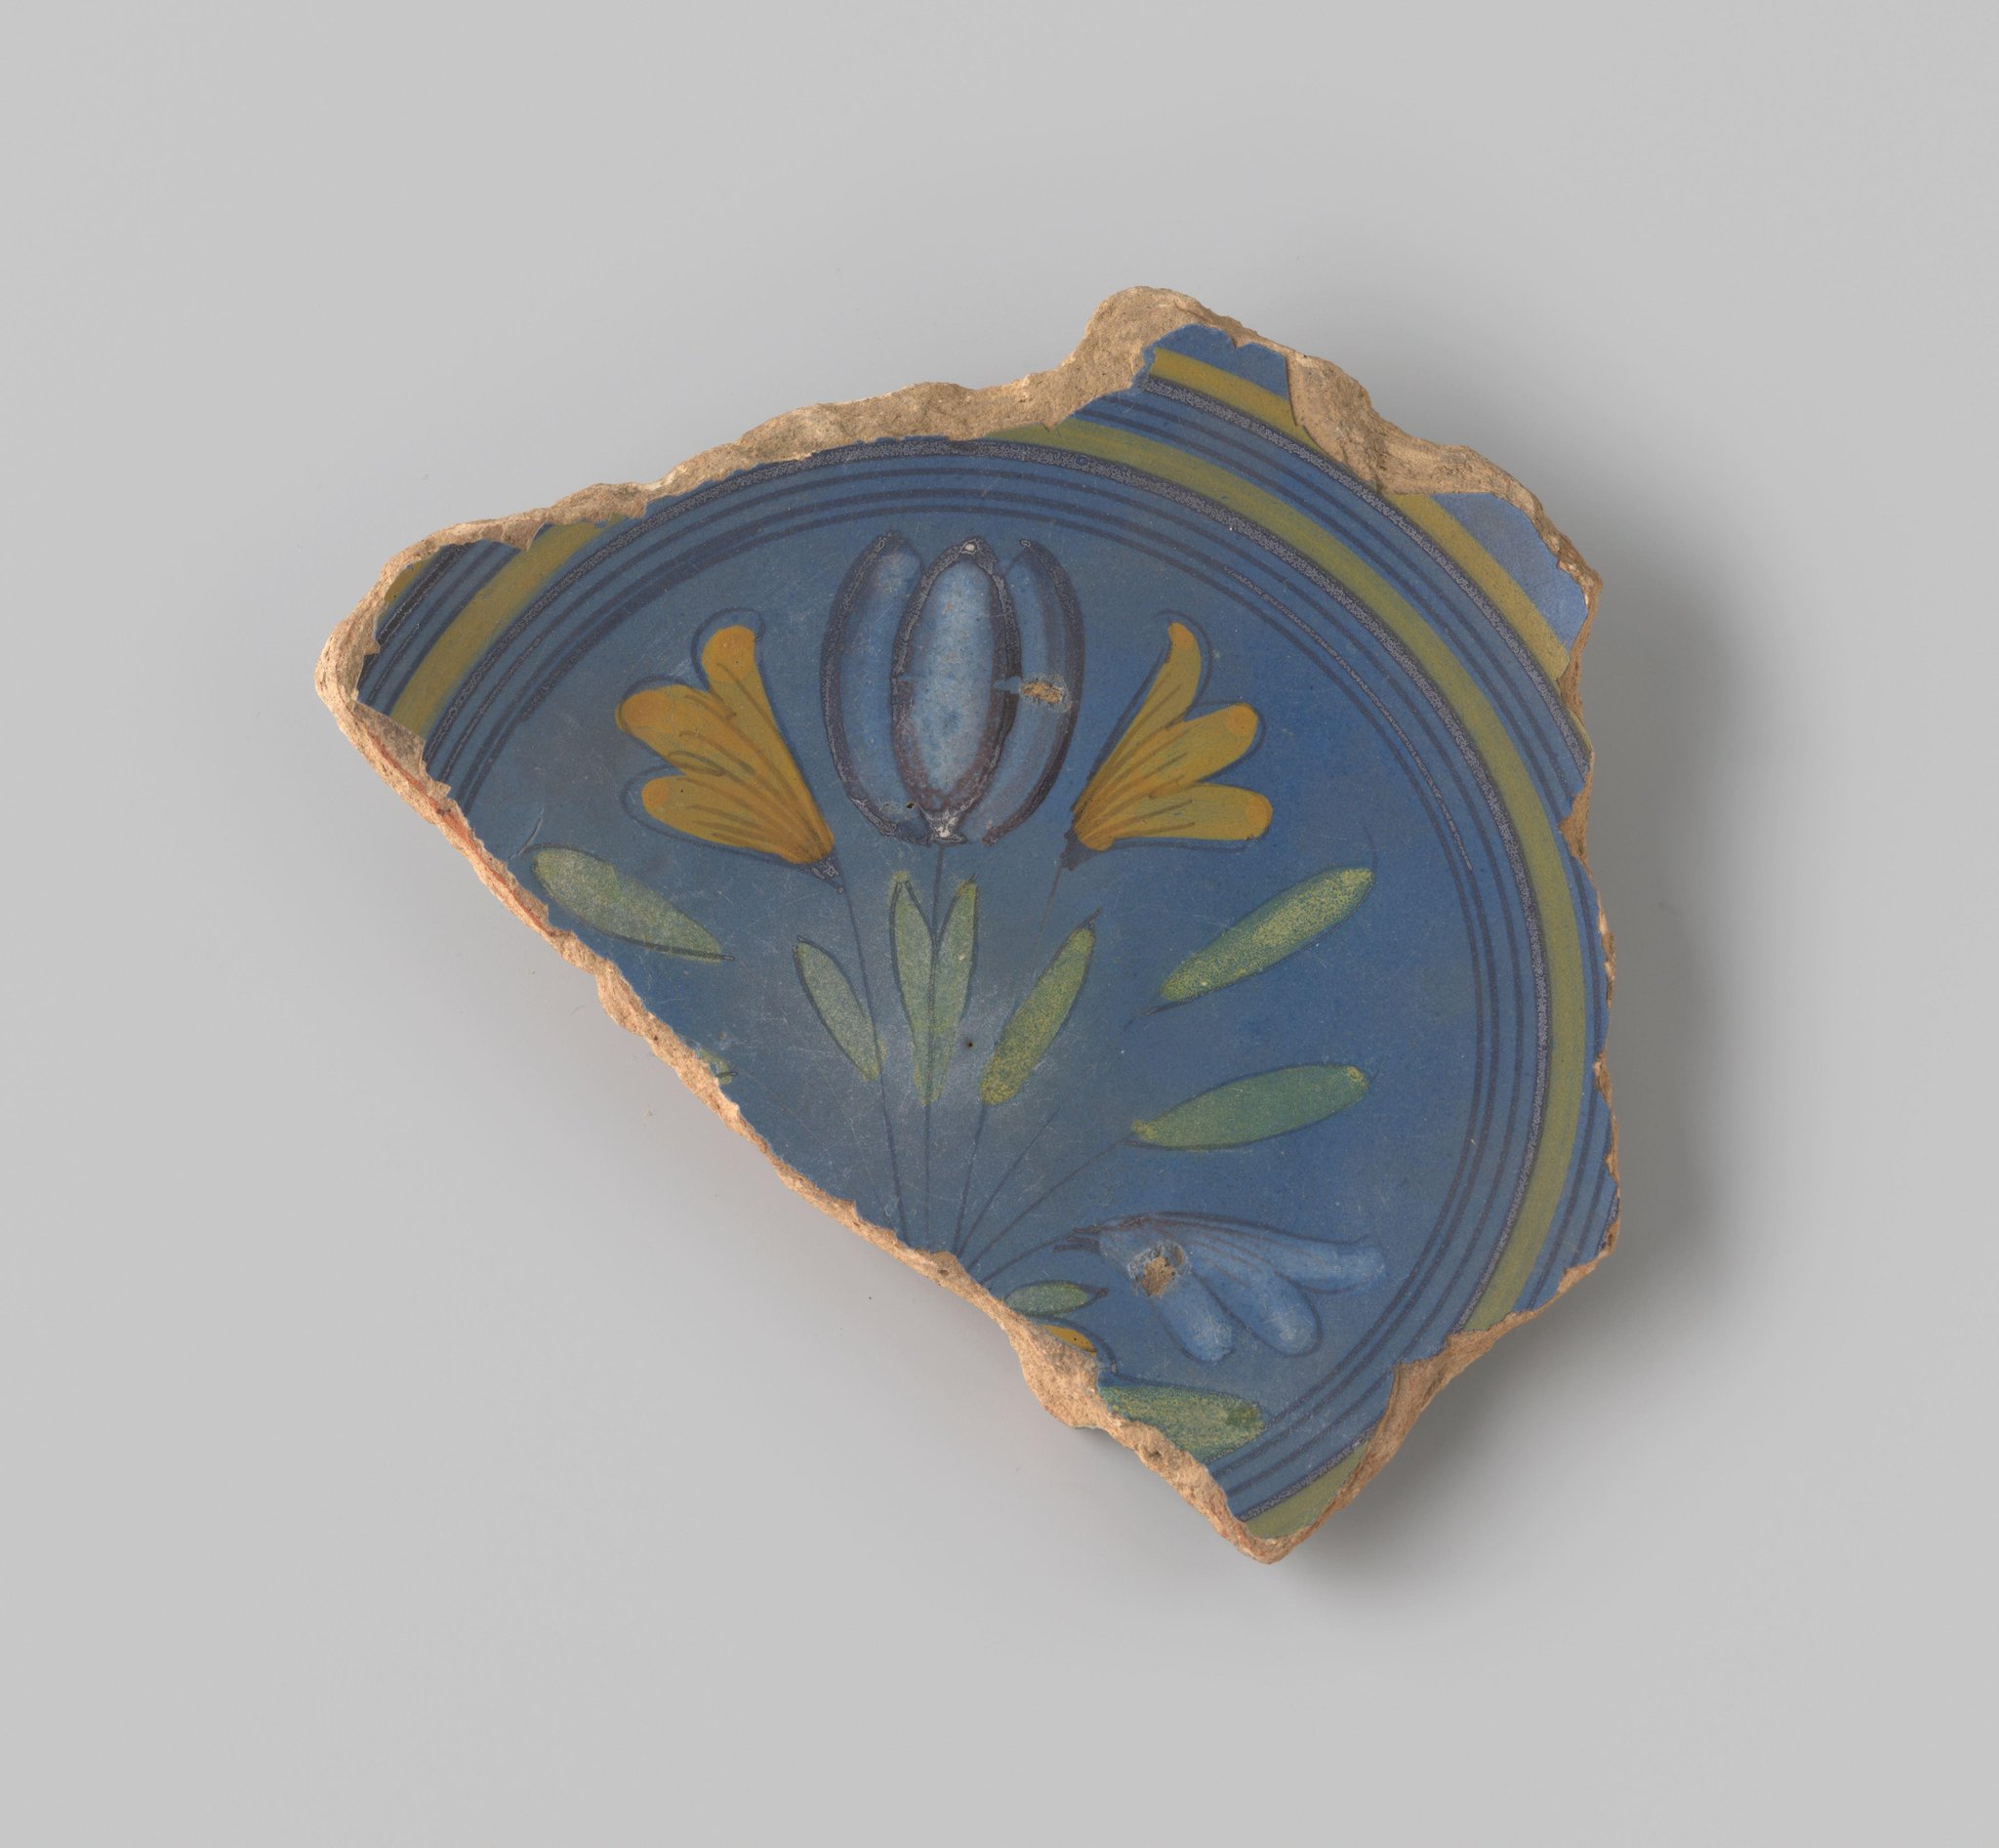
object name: sherd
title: Scherf van rossigbakkend aardewerk, aan de bovenzijde voorzien van blauw glazuur met decoratie van een tafereel met 4 bloemen die in de aarde staan in bruin, wit, geel, oranje en groen, en enkele cirkels in bruin en geel eromheen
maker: Anonymous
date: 1600-1650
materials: earthenware, glaze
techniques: maiolica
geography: northern netherlands